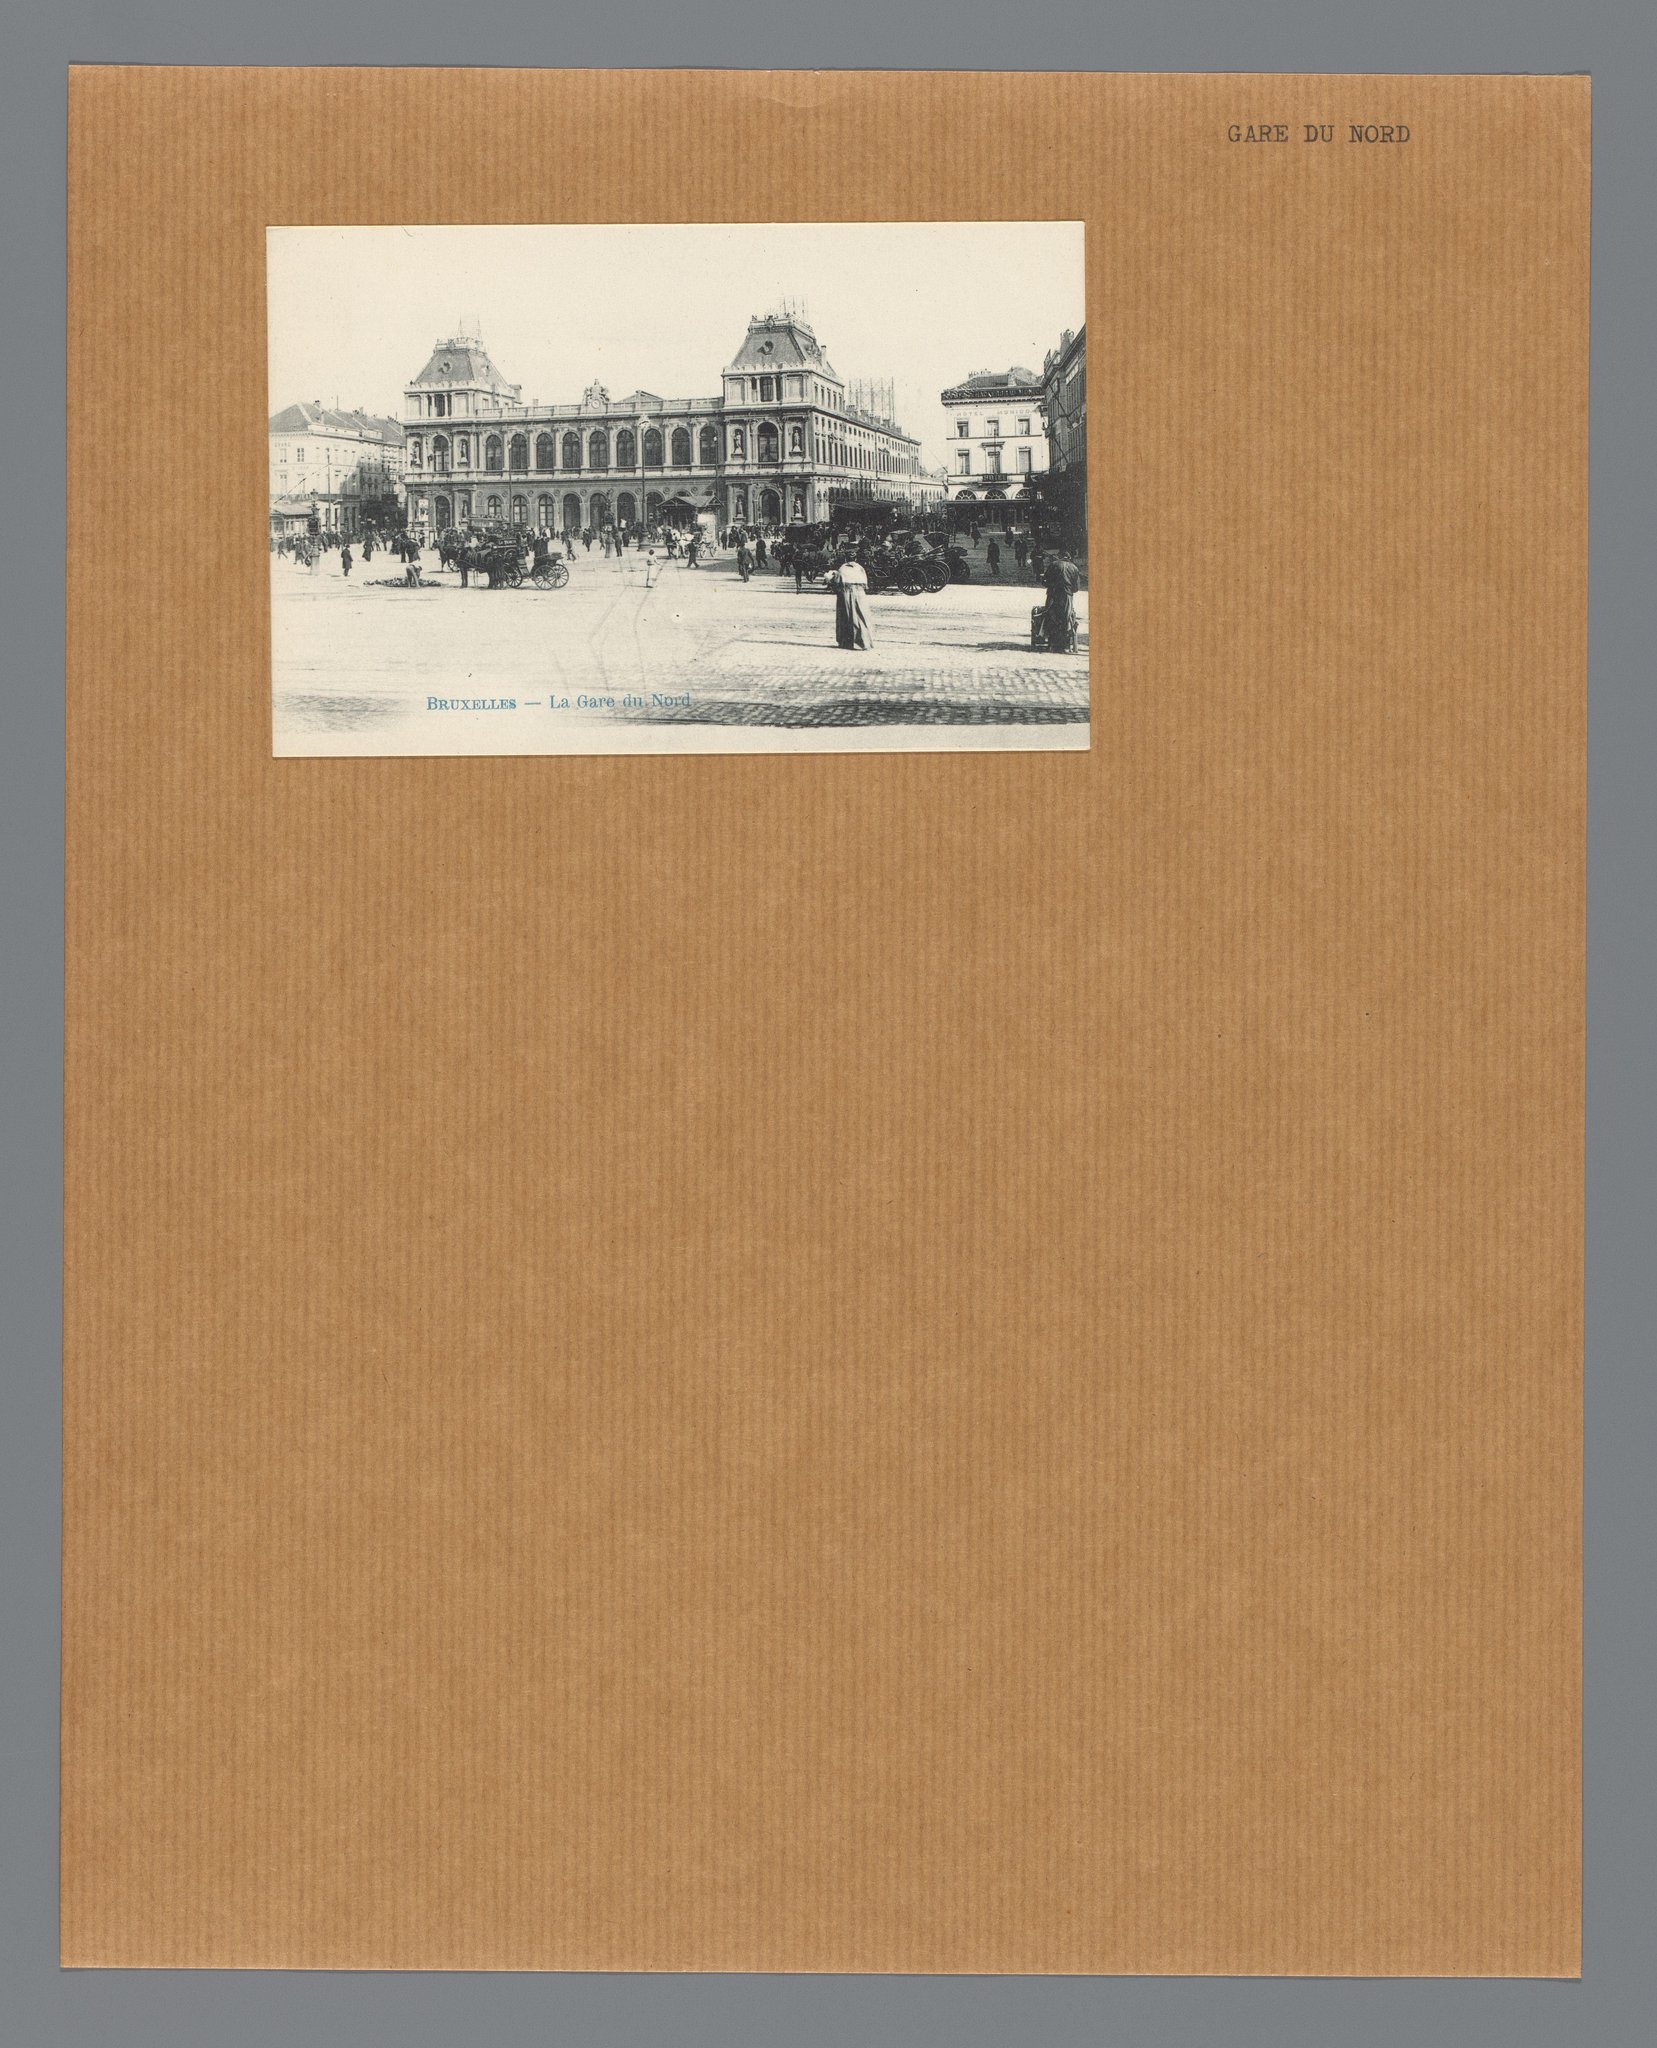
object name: photograph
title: Brussel. Gare du Nord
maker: Anonymous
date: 1860-1925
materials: photographic support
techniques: photograph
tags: brussels